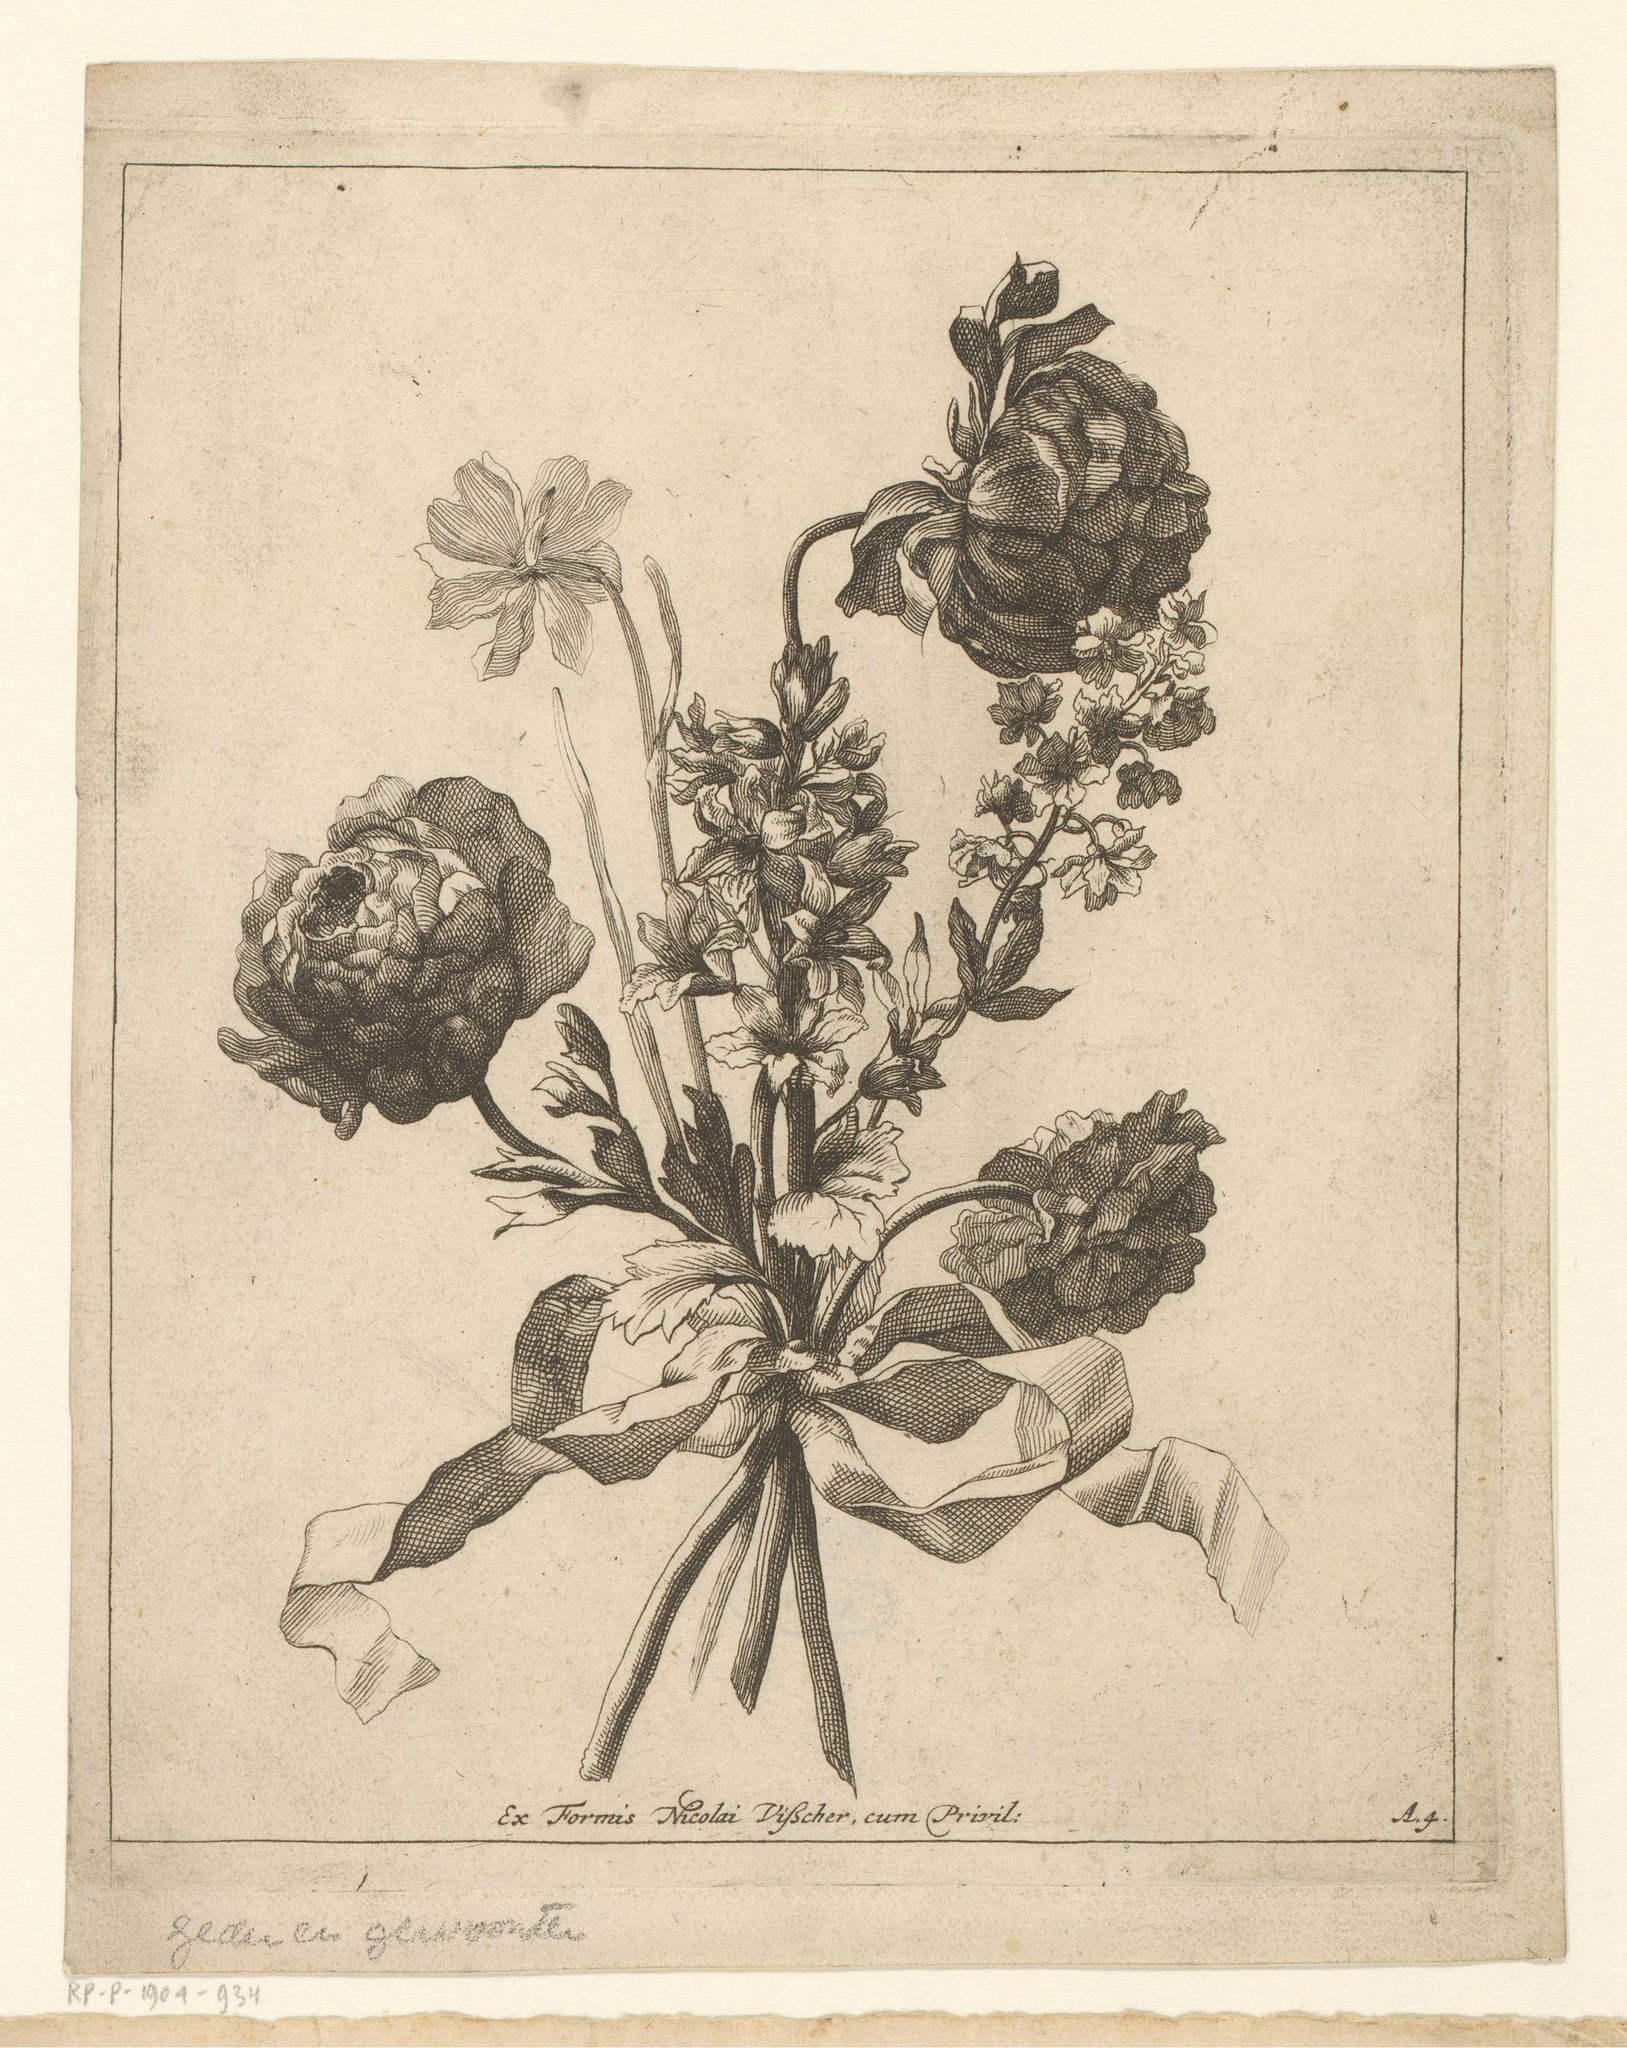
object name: print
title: Drie pioenrozen met narcis in boeket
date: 1679-1702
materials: paper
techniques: etching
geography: amsterdam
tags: cut flowers; nosegay, bunch of flowers, flowers: peony, flowers: narcissus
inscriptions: collector's mark: Lugt 2228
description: Rechtsonder genummerd: A4. Tussen de pioenrozen en de narcis takjes met kleinere bloemen.